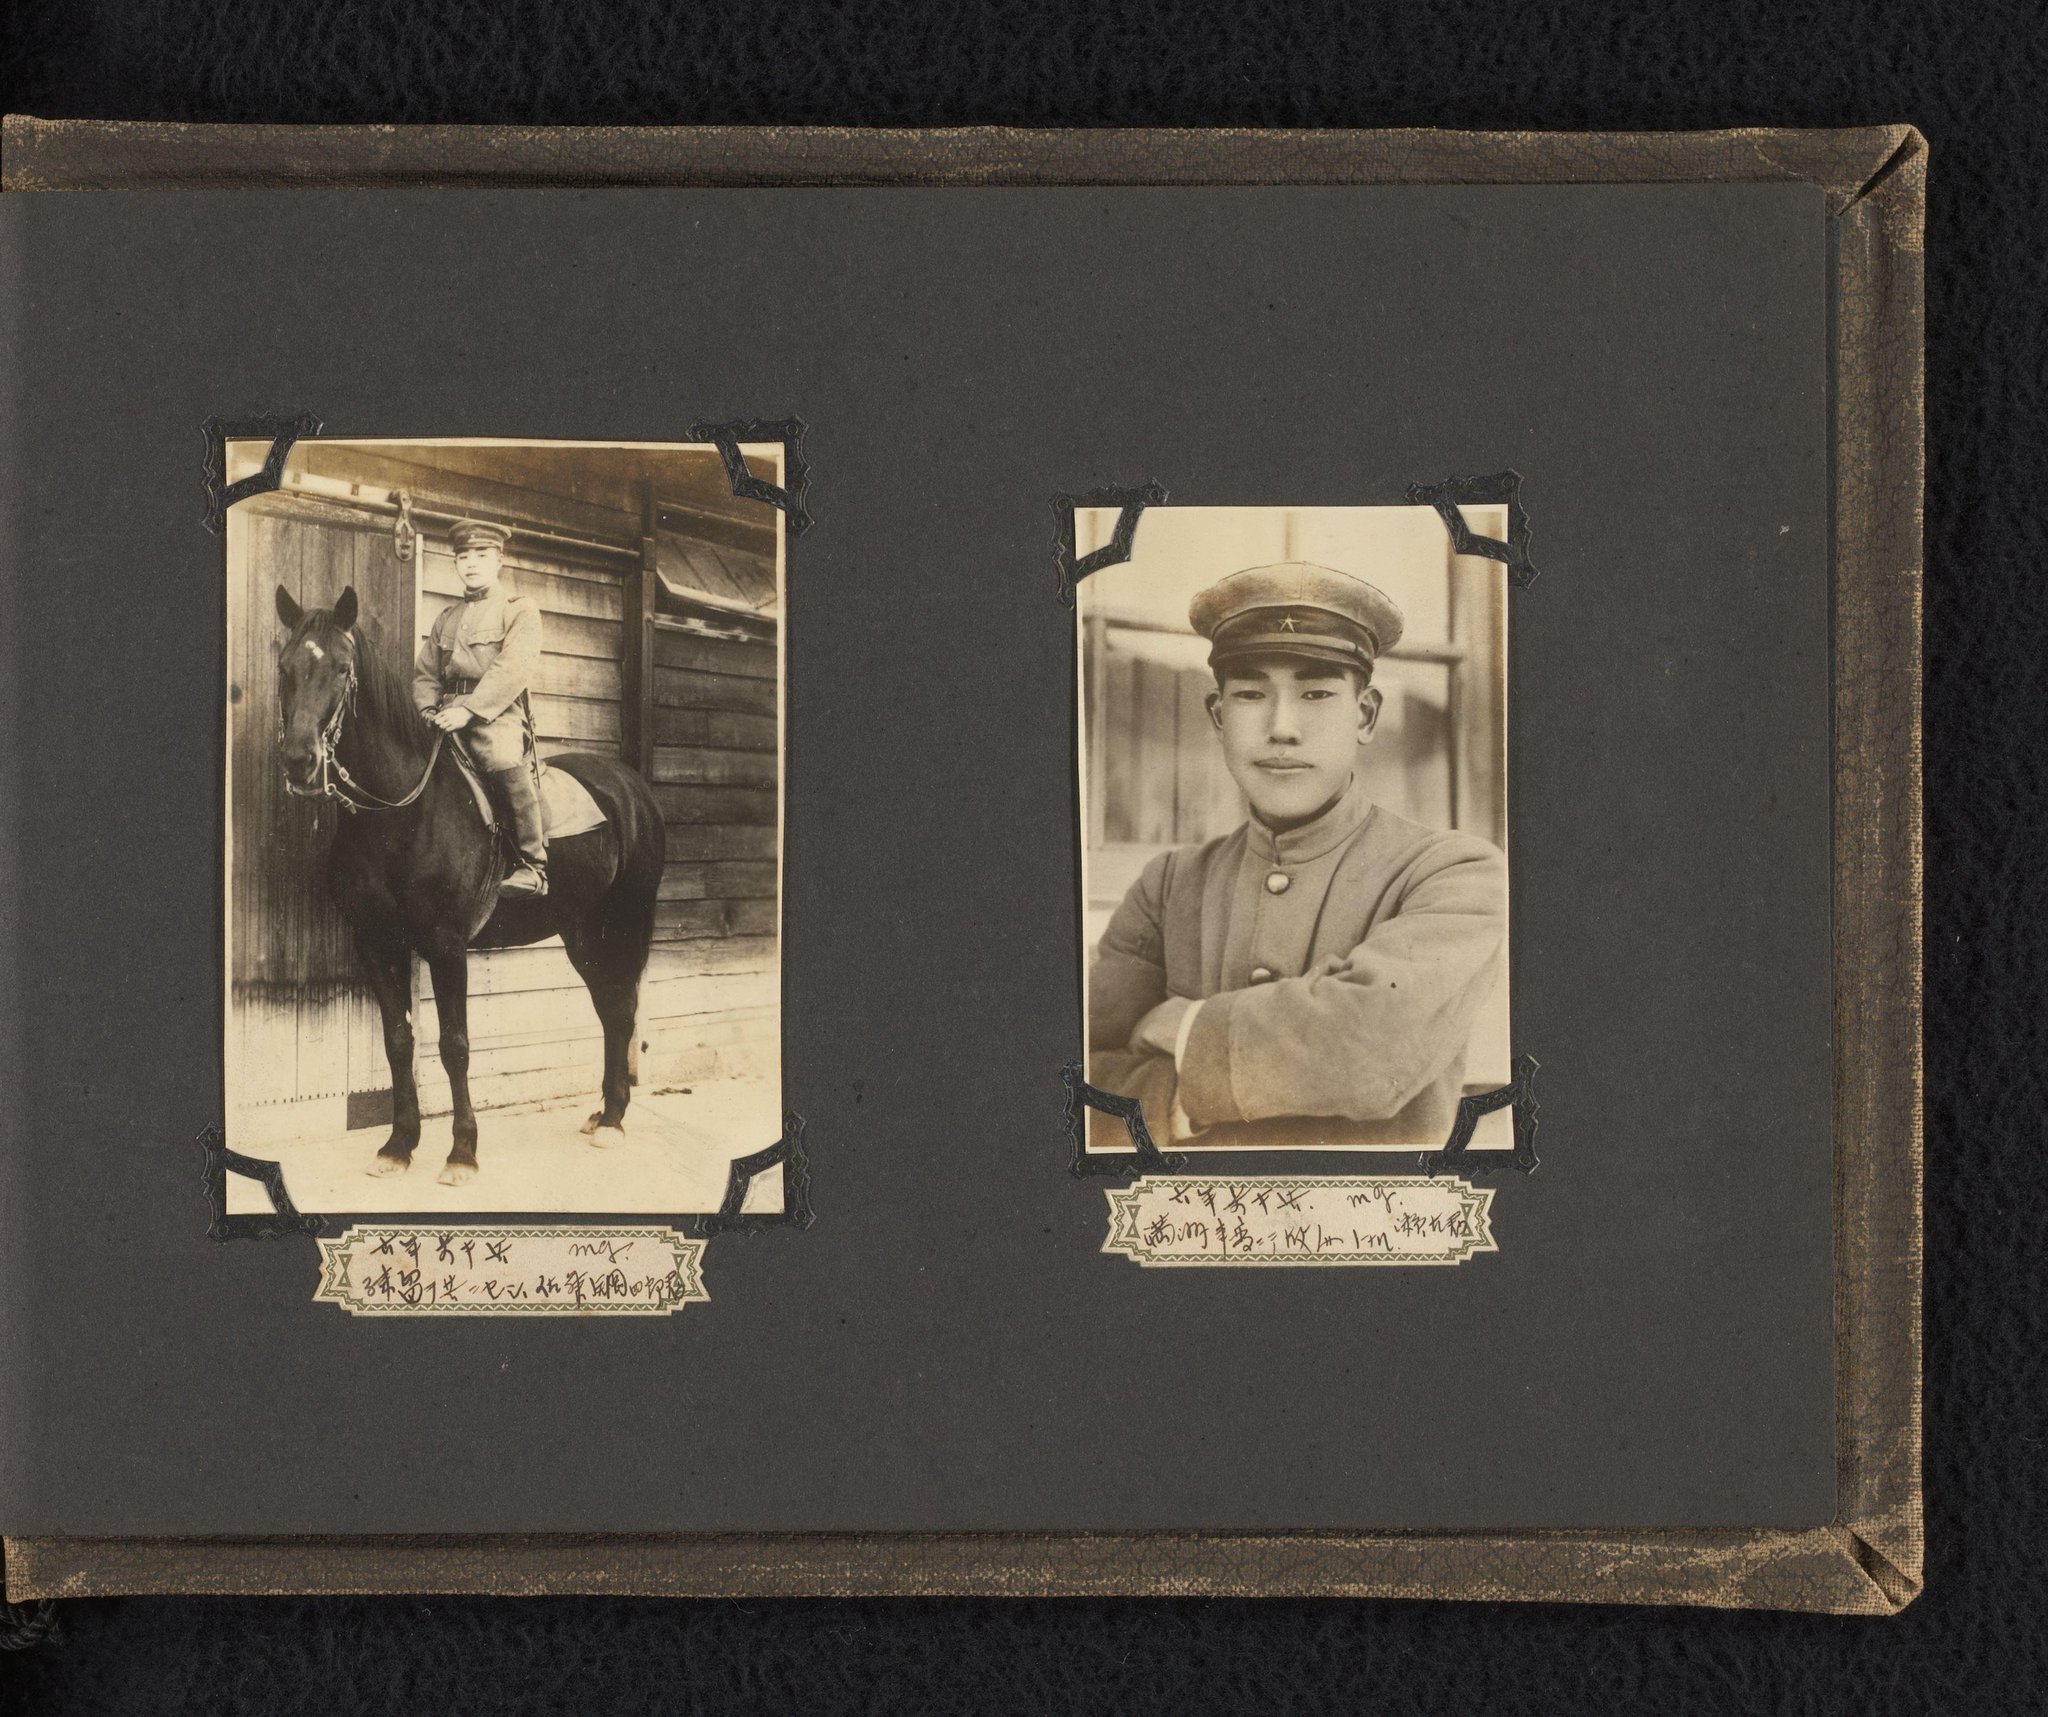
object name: photograph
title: Twee portretten van onbekende Japanse soldaten, een te paard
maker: Anonymous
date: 1930-1940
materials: paper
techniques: gelatin silver print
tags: anonymous historical person portrayed, the soldier; the soldier's life, horse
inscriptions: inscription: ‘[...]’